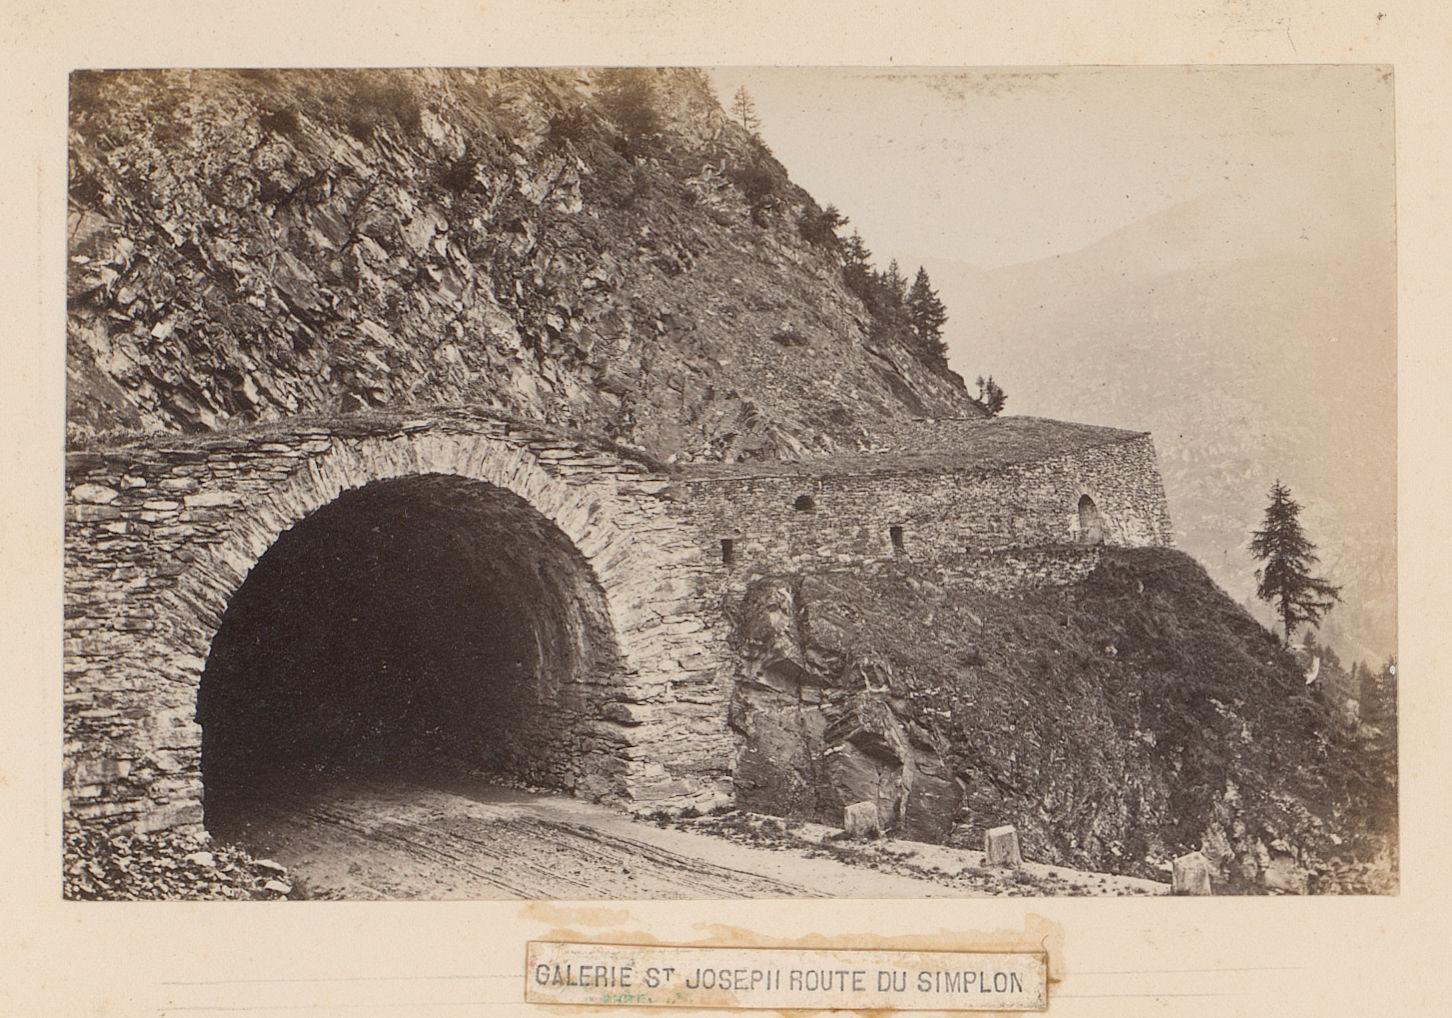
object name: photograph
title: Galerie St. Joseph Route du Simplon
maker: Anonymous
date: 1860-1890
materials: paper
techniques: albumen print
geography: simplonpas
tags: underground road, tunnel, mountains